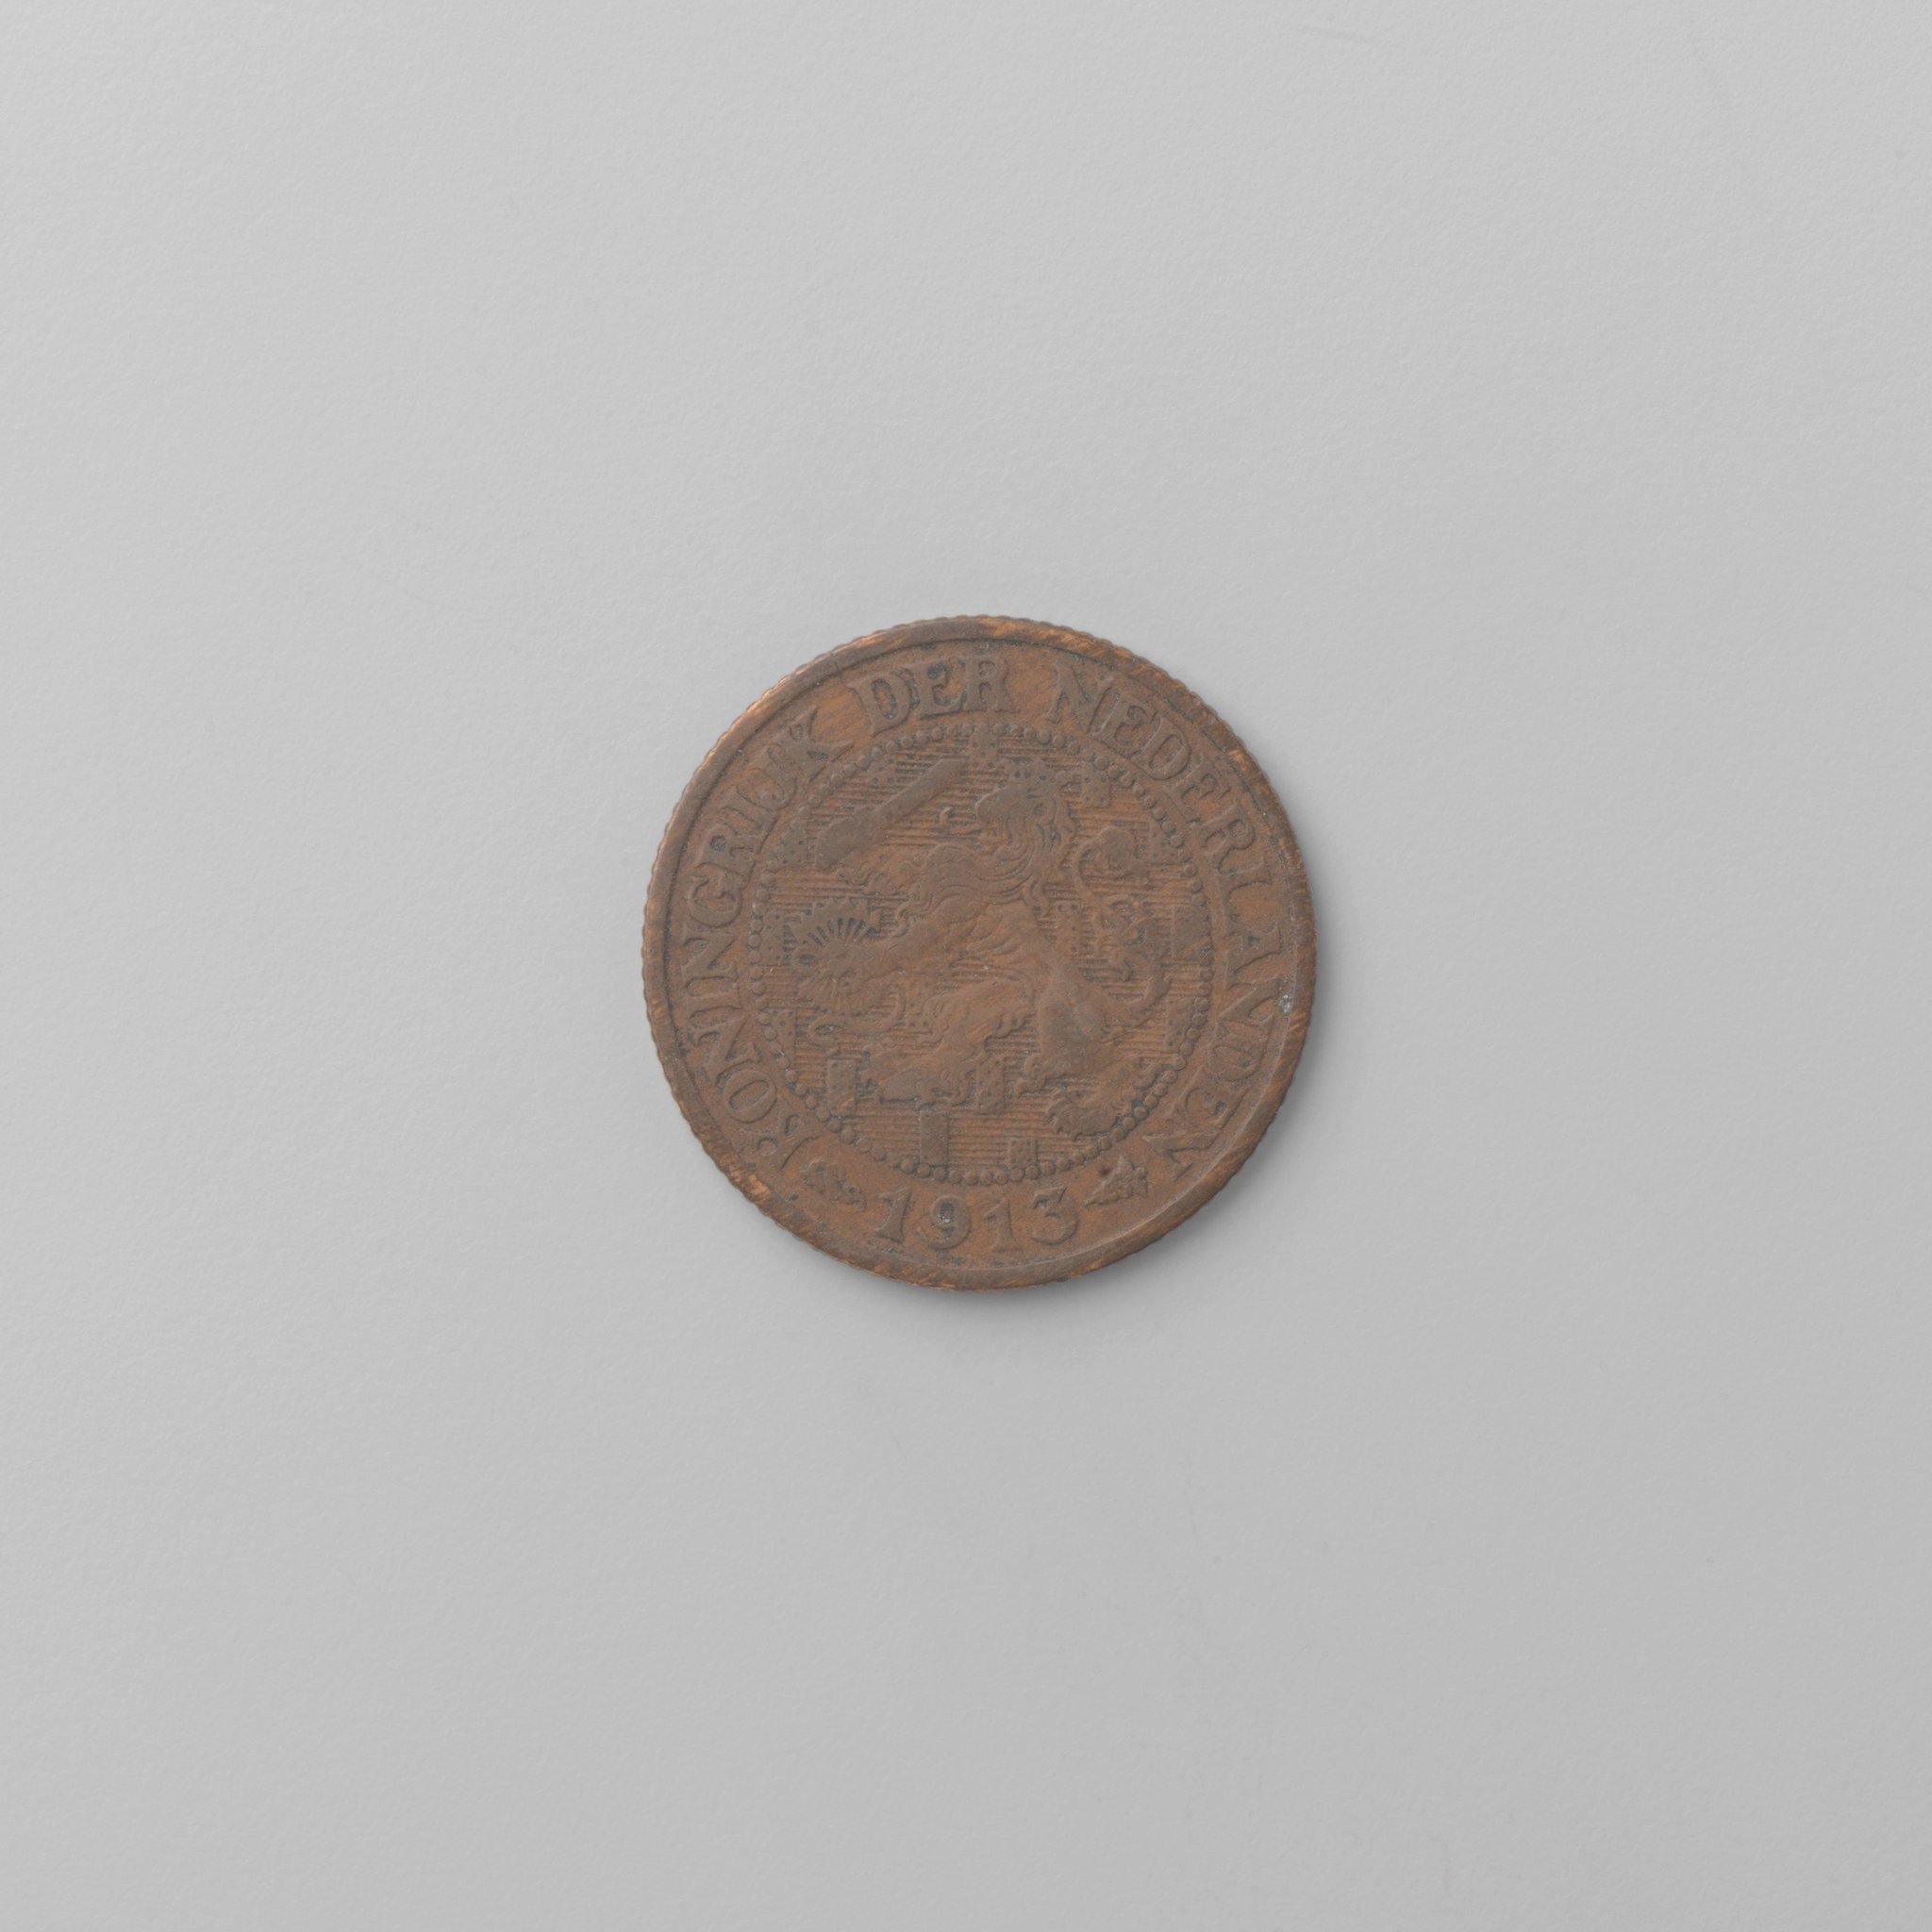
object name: coin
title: Nederland, cent,1913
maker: wilhelmina of the netherlands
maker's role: print maker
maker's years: 1880-1962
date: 1913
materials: bronze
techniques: striking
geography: utrecht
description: Bronzen munt. Voorzijde: in een veld rijkswapen. Jaartal onderaan in omschrift. Keerzijde: binnen twee samengebonden oranjetakken waarde-aanduiding 1 cent. Kartelrand.